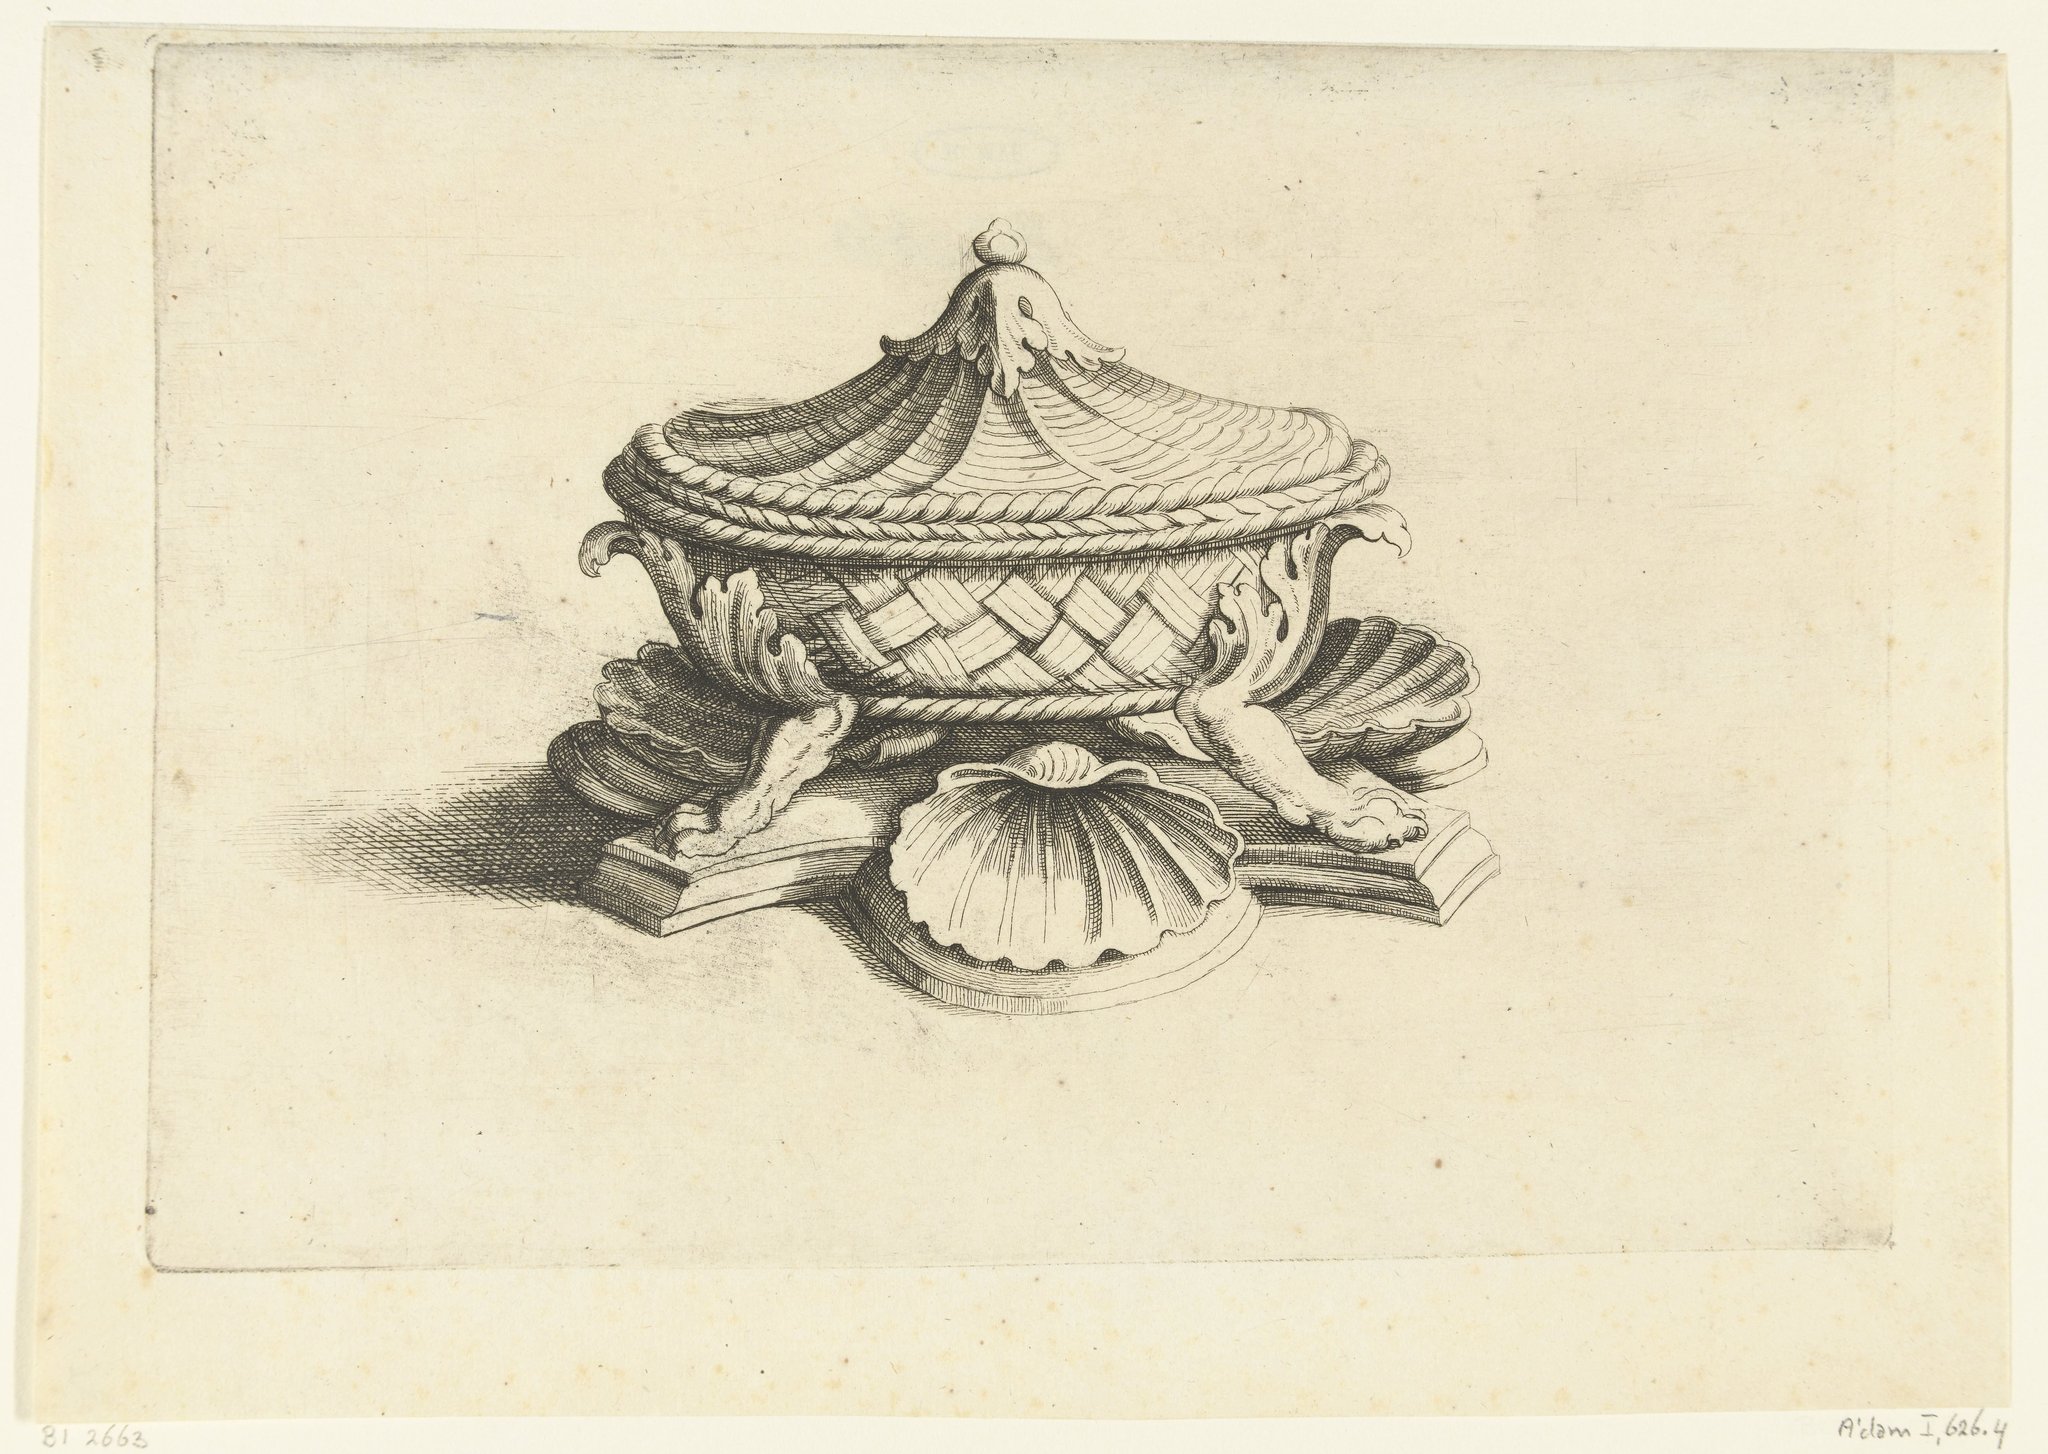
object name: ornament print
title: Gevlochten mand met deksel op klauwtjes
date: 1614-1654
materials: paper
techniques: etching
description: Uit serie van 14 bladen met schalen, kommen en kistjes.